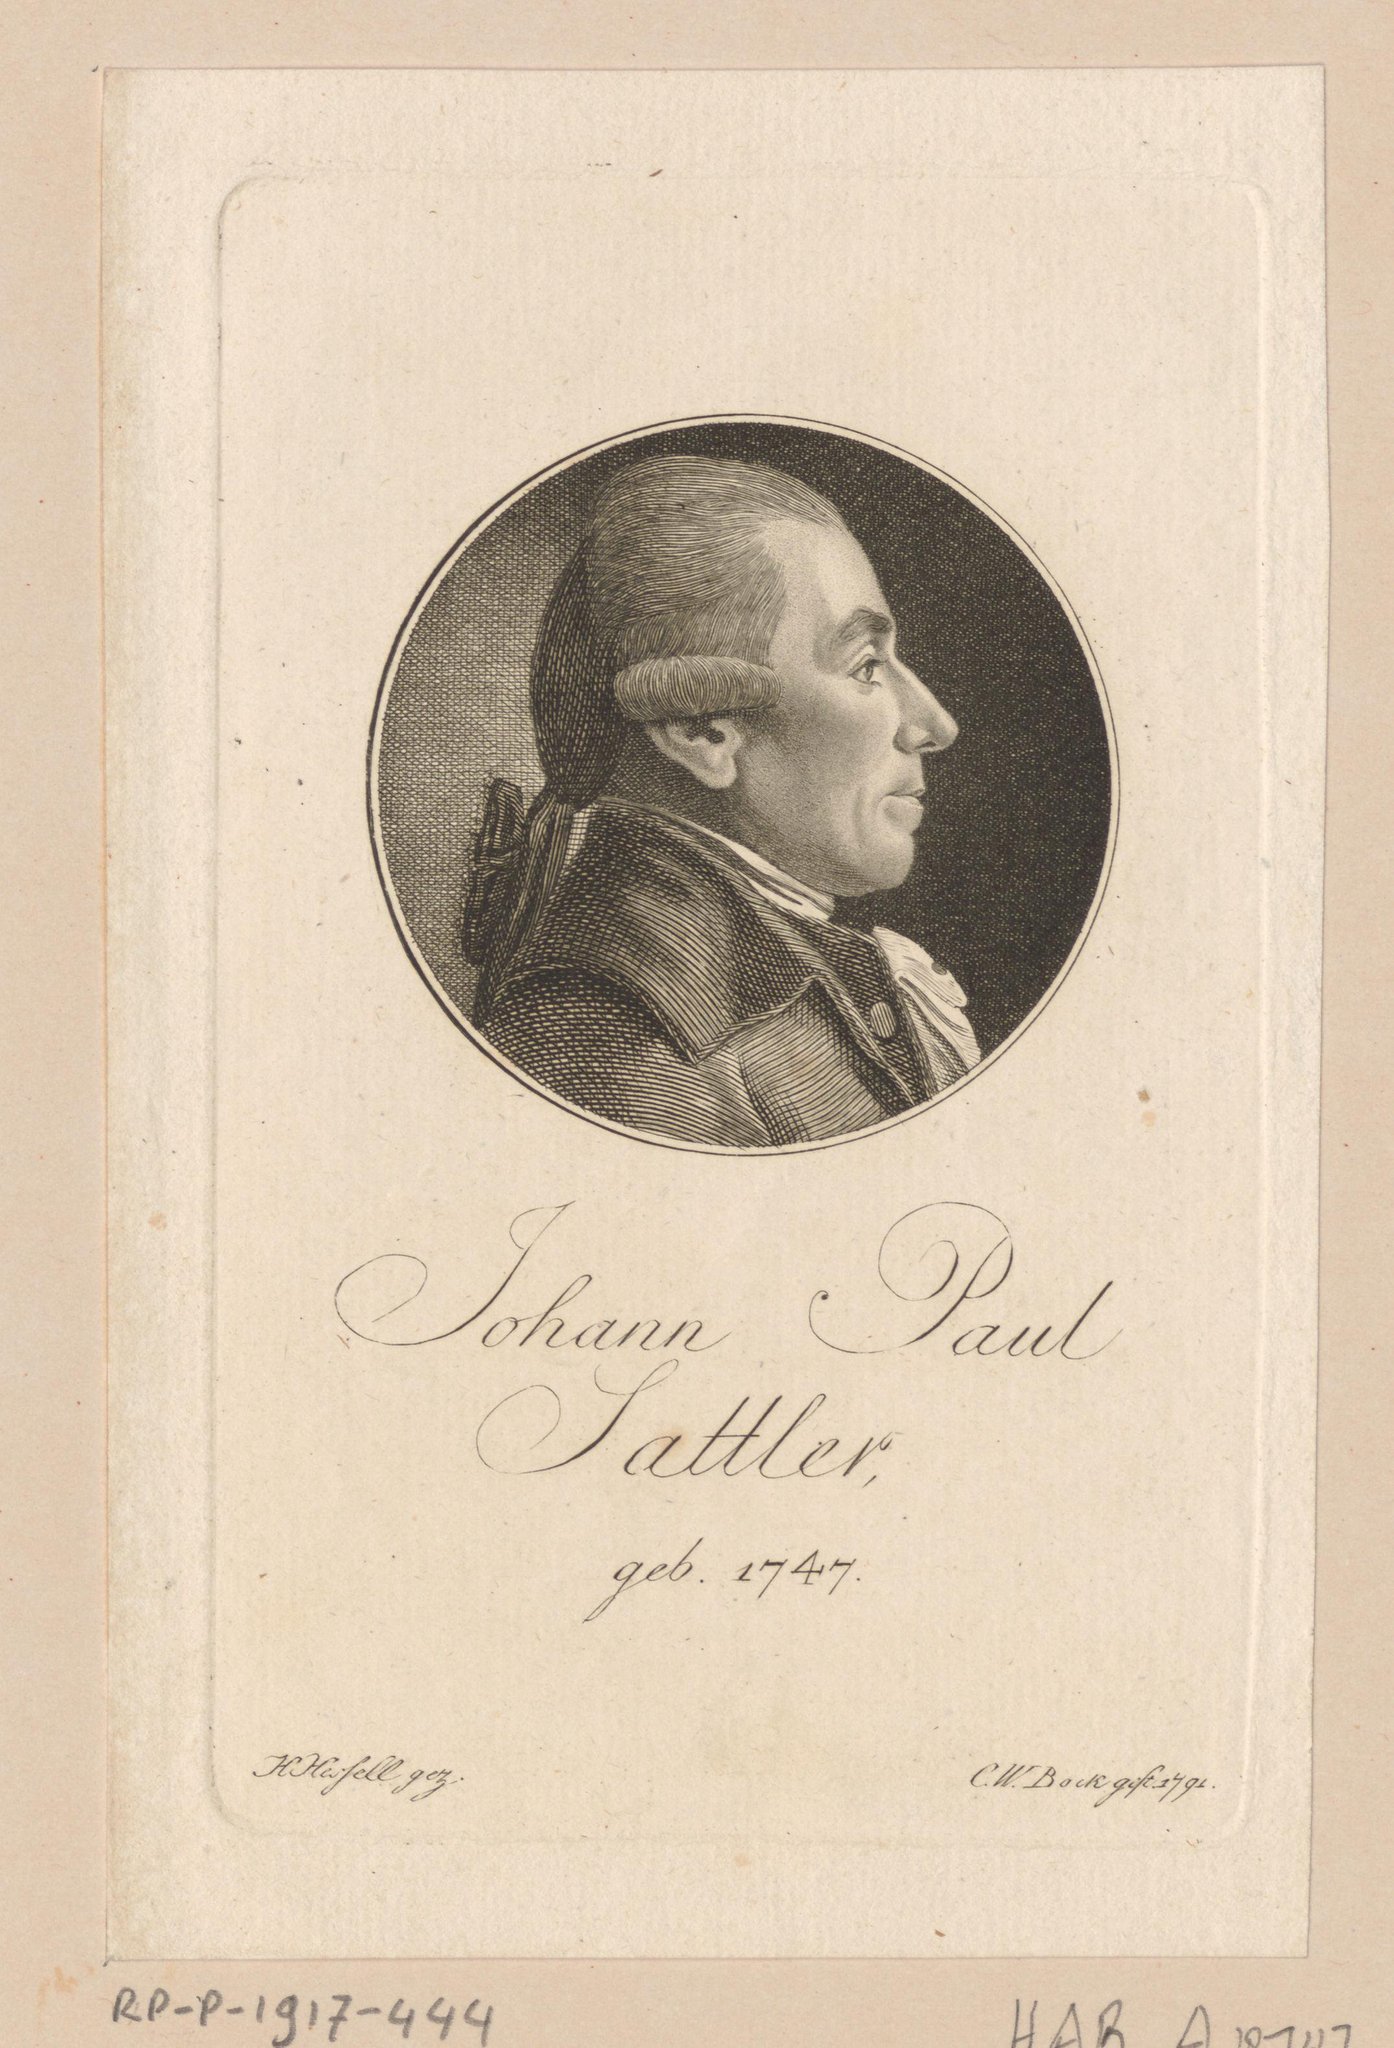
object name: print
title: Portret van Johann Paul Sattler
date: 1791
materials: paper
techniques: engraving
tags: historical persons, professor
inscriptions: collector's mark: Lugt 2228